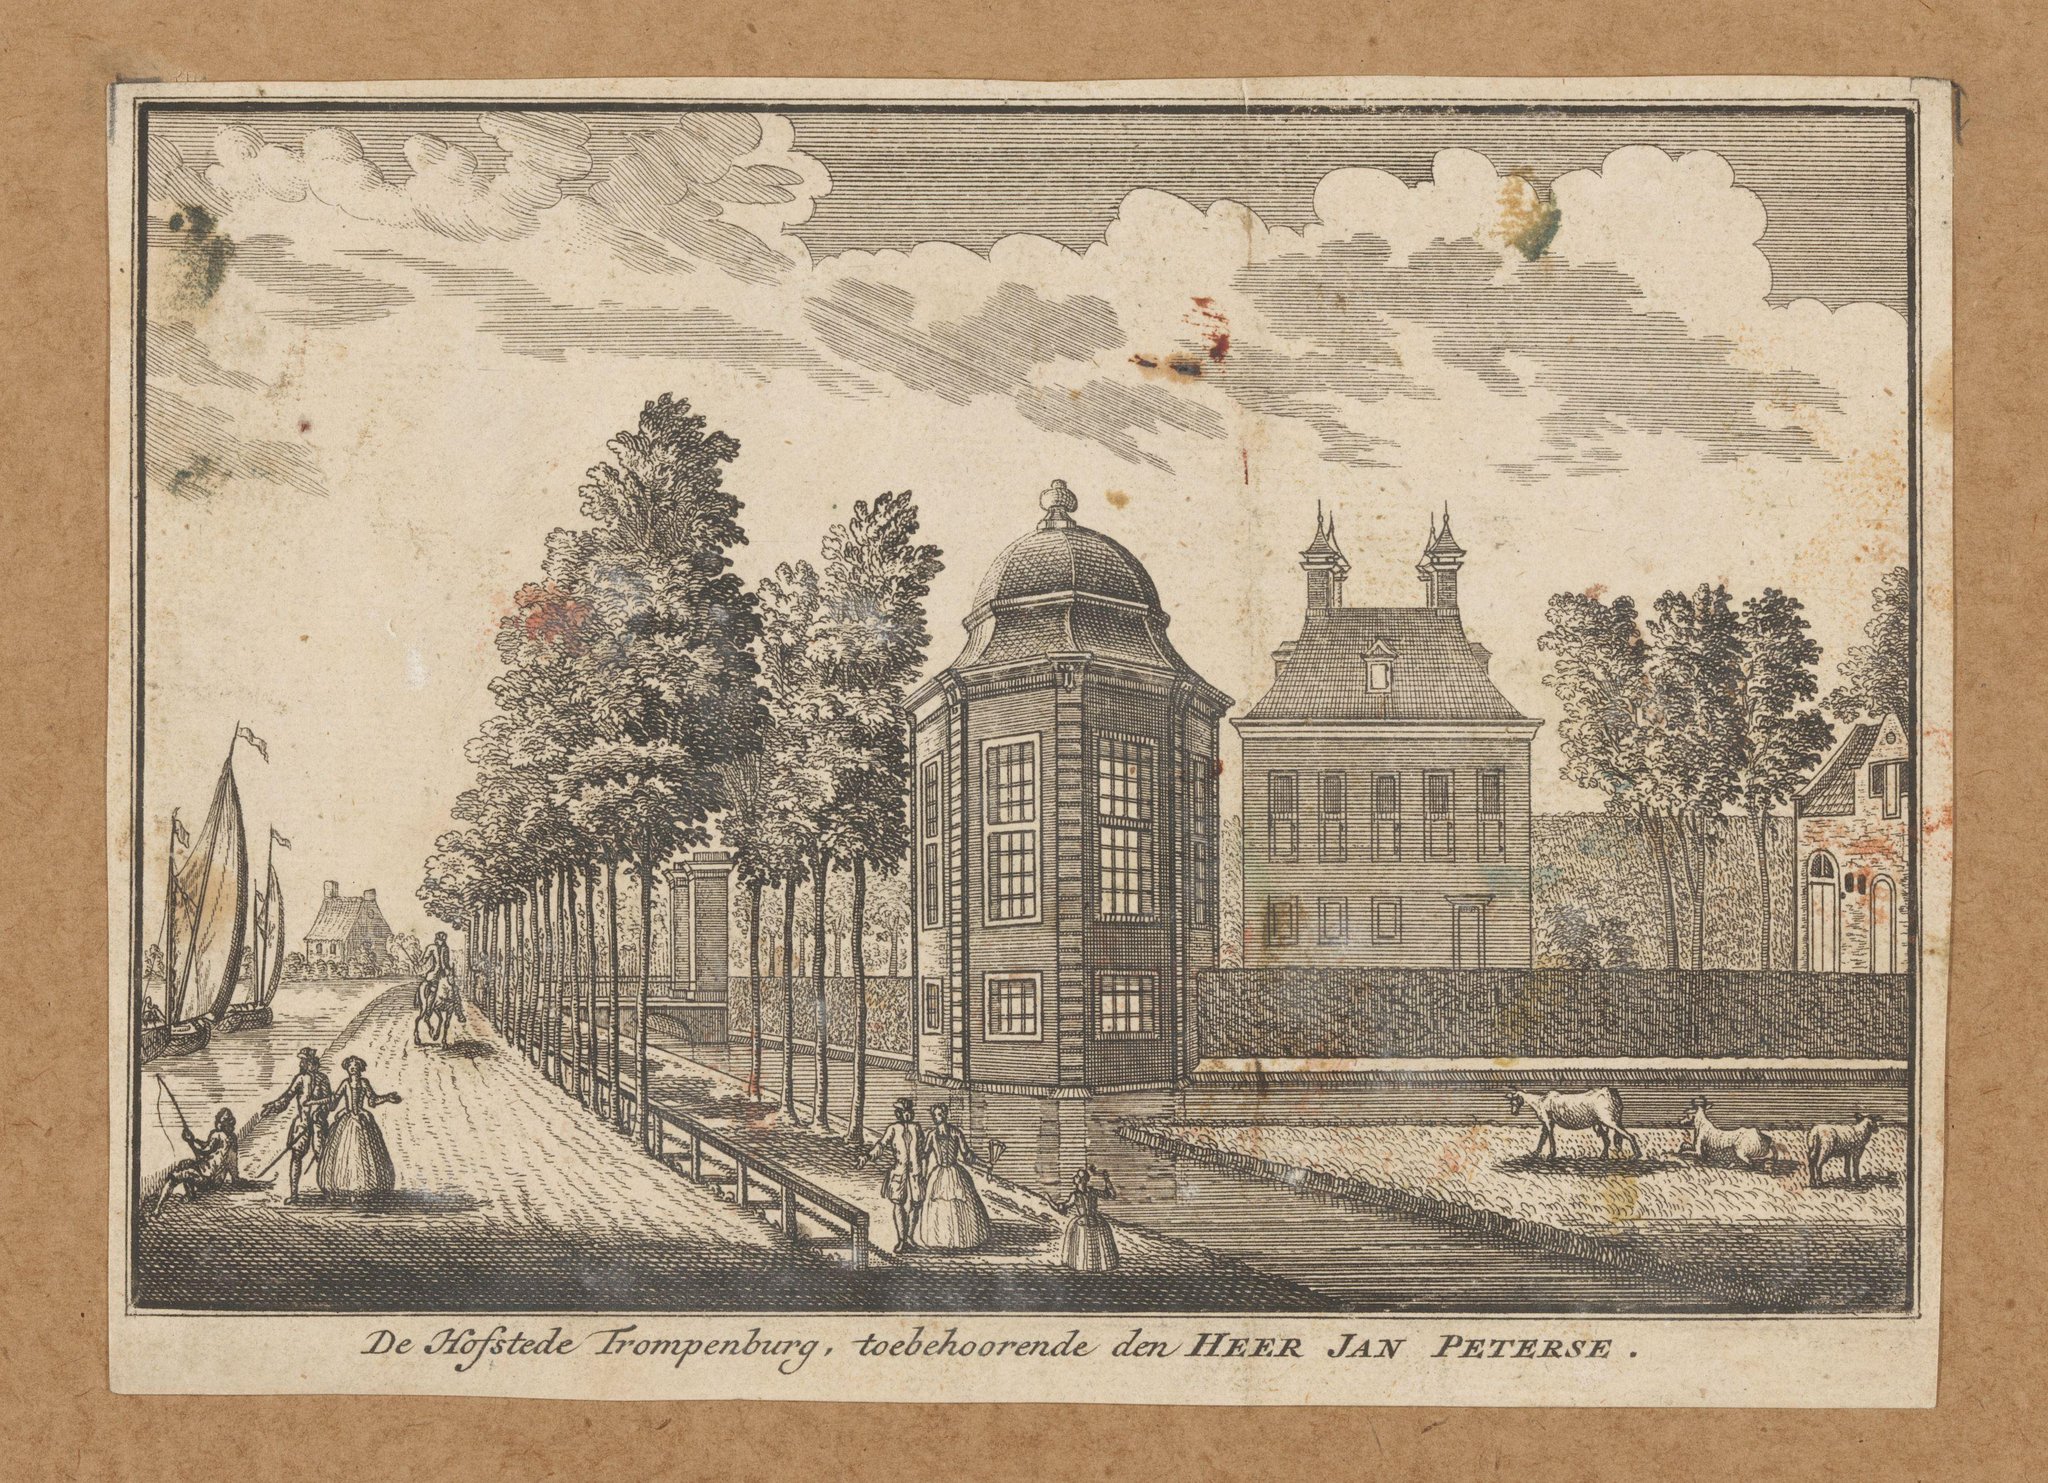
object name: print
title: De Hofstede Trompenburg, toebehoorende den Heer Jan Peterse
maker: Anonymous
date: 1700-1735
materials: paper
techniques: etching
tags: civic architecture; edifices; dwellings